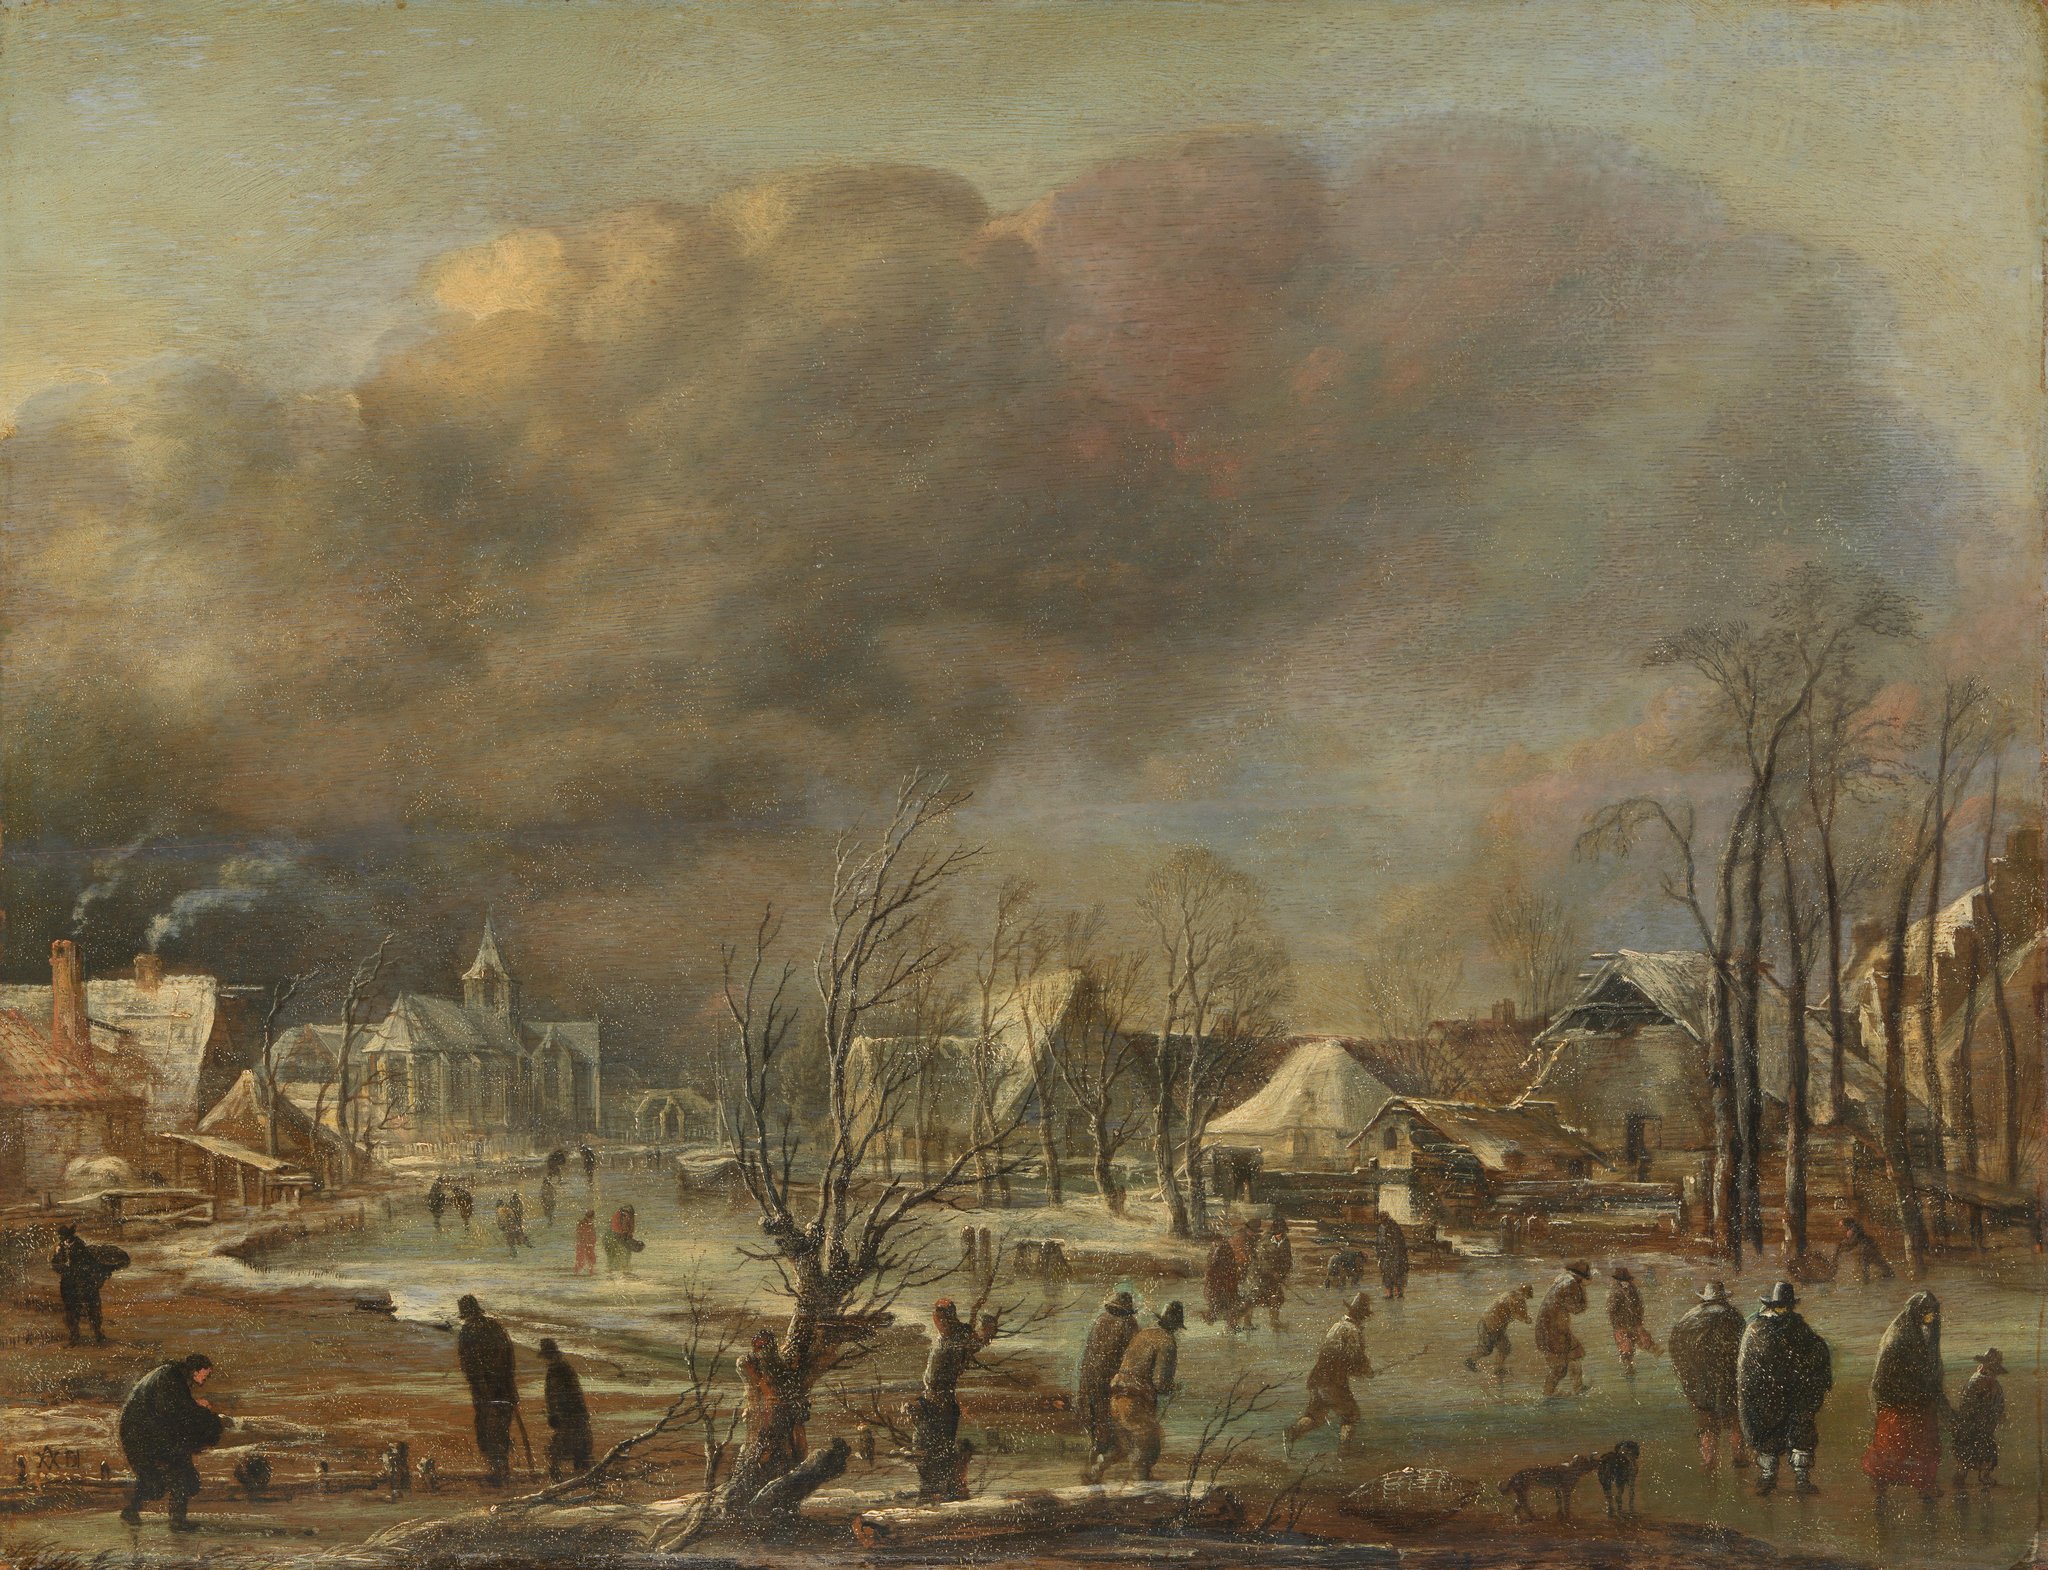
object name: painting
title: Winter Landscape with Church and Farmhouses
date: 1775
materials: oil, panel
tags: ice ~ freezing weather, winter landscape; landscape symbolizing winter (the four seasons of the year), skates (winter sports), village (+ city(-scape) with figures, staffage)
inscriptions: signature, with monogram, lower left (AV and DN ligated): ‘AV DN’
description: Gezicht op een dorp aan een bevroren vaart tijdens een sneeuwbui. Donkere wolken hangen boven het dorp. Op het ijs bevinden zich kolfspelers en schaatsers. Links in de verte een kerk.